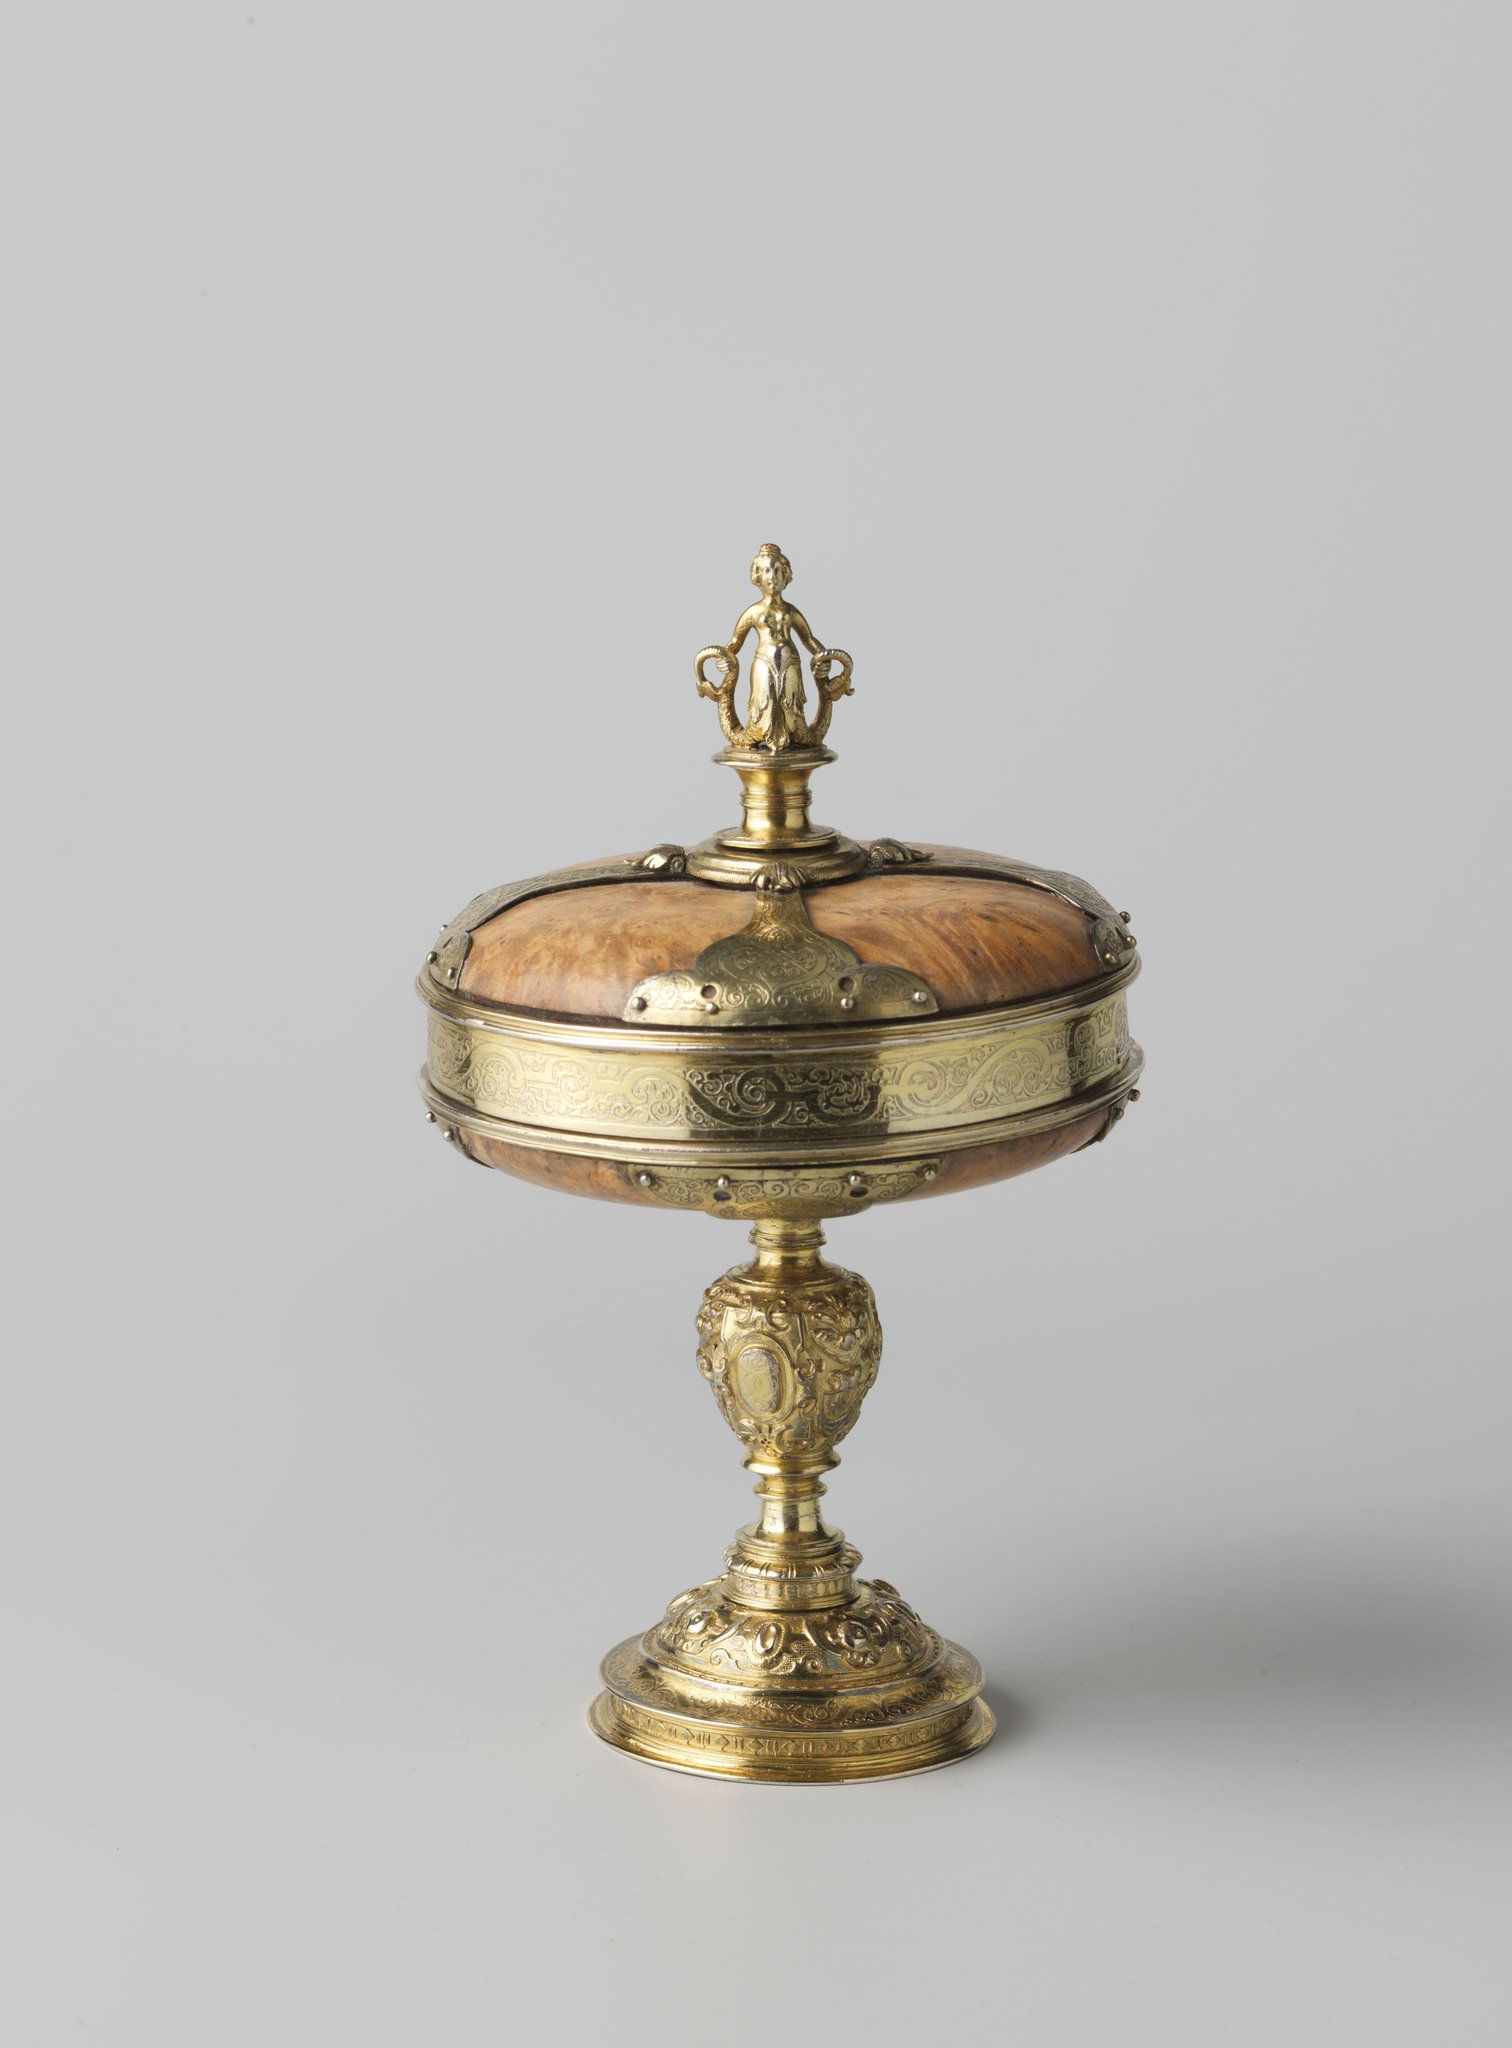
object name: goblet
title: Bokaal van wortelhout met montuur van verguld zilver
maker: Anonymous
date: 1550-1600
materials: silver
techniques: gilding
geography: nuremberg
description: Goblet. Burr wood and silver-gilt. Nuremberg (?), c. 1550-1600.